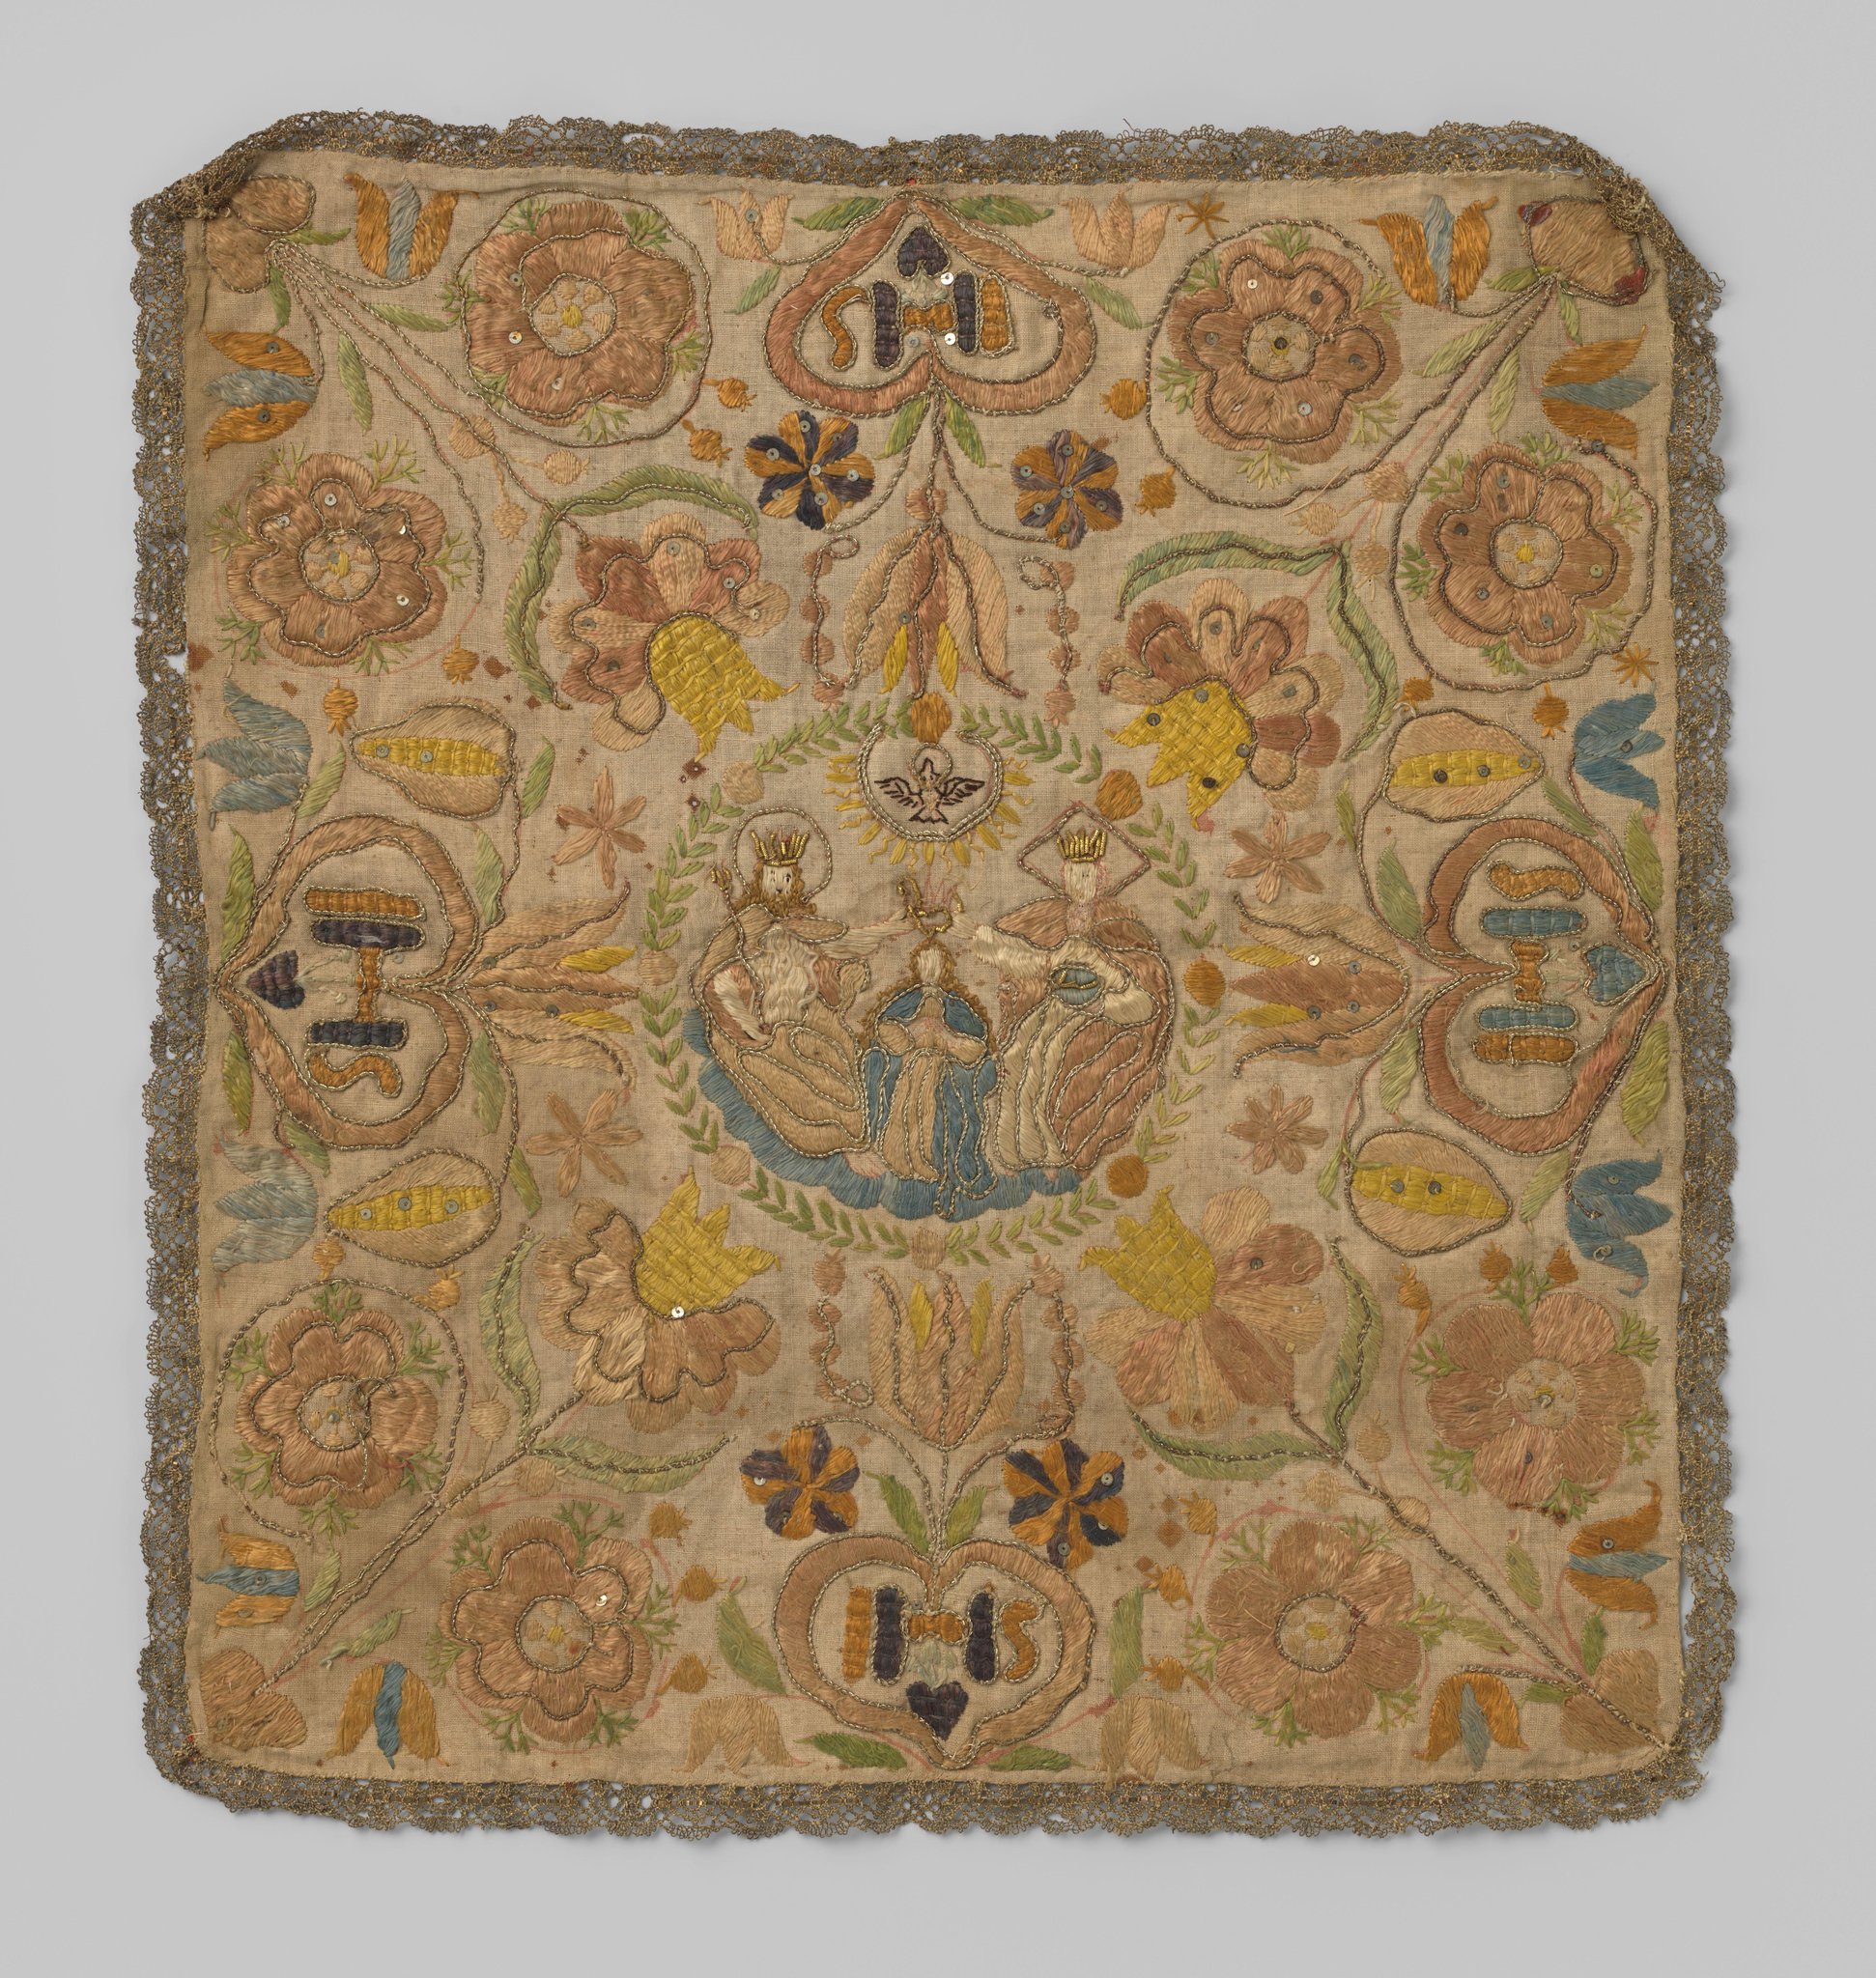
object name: chalice veil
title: Kelkkleed van linnen met borduurwerk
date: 1660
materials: gold thread, linen, silk, thread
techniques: embroidered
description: Kelkkleed van linnen met borduurwerk van zijde, gouddraad en zilverdraad en pailletten. Het patroon heeft in het midden een bladkrans waarbinnen de kroning van Maria. Het kleed is afgewerkt met een smalle strook goudkant.